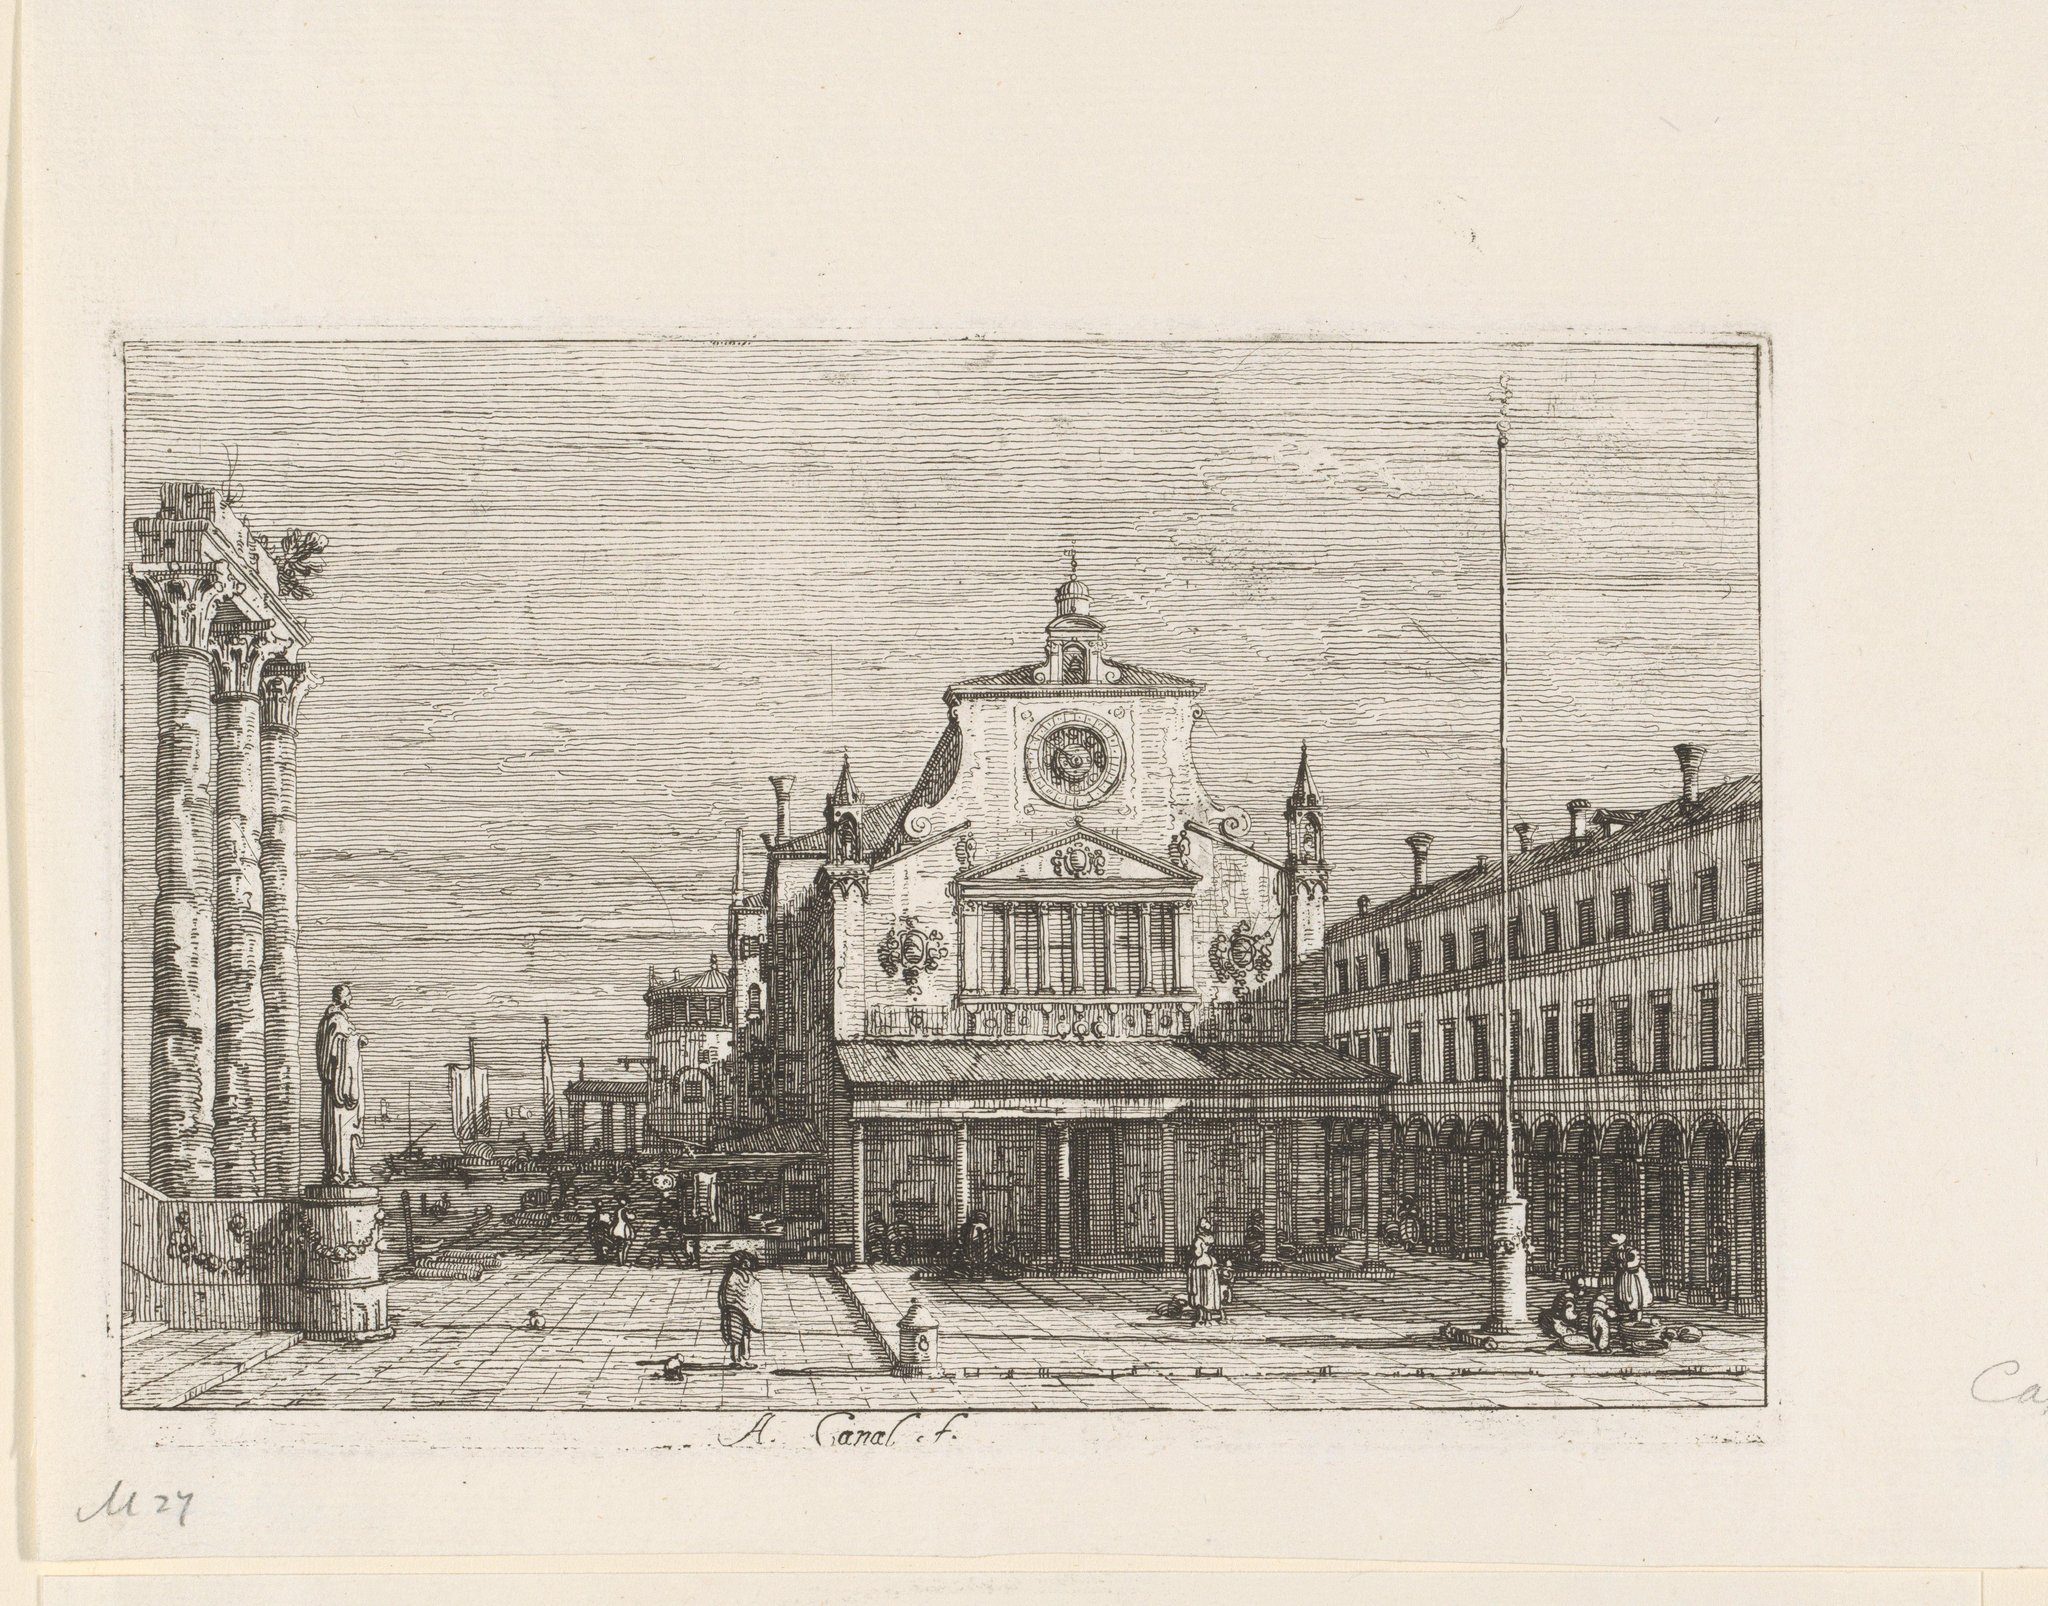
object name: print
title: Gezichten op bestaande en verzonnen plaatsen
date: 1707-1768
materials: paper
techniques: etching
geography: venice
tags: square, place, circus, etc., ruin of a building ~ architecture, church (exterior), venice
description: Gezicht op een plein met een kerk, gebaseerd op de S. Giacomo di Rialto in Venetië. Links drie zuilen en een standbeeld. Rechts een vlaggenmast.